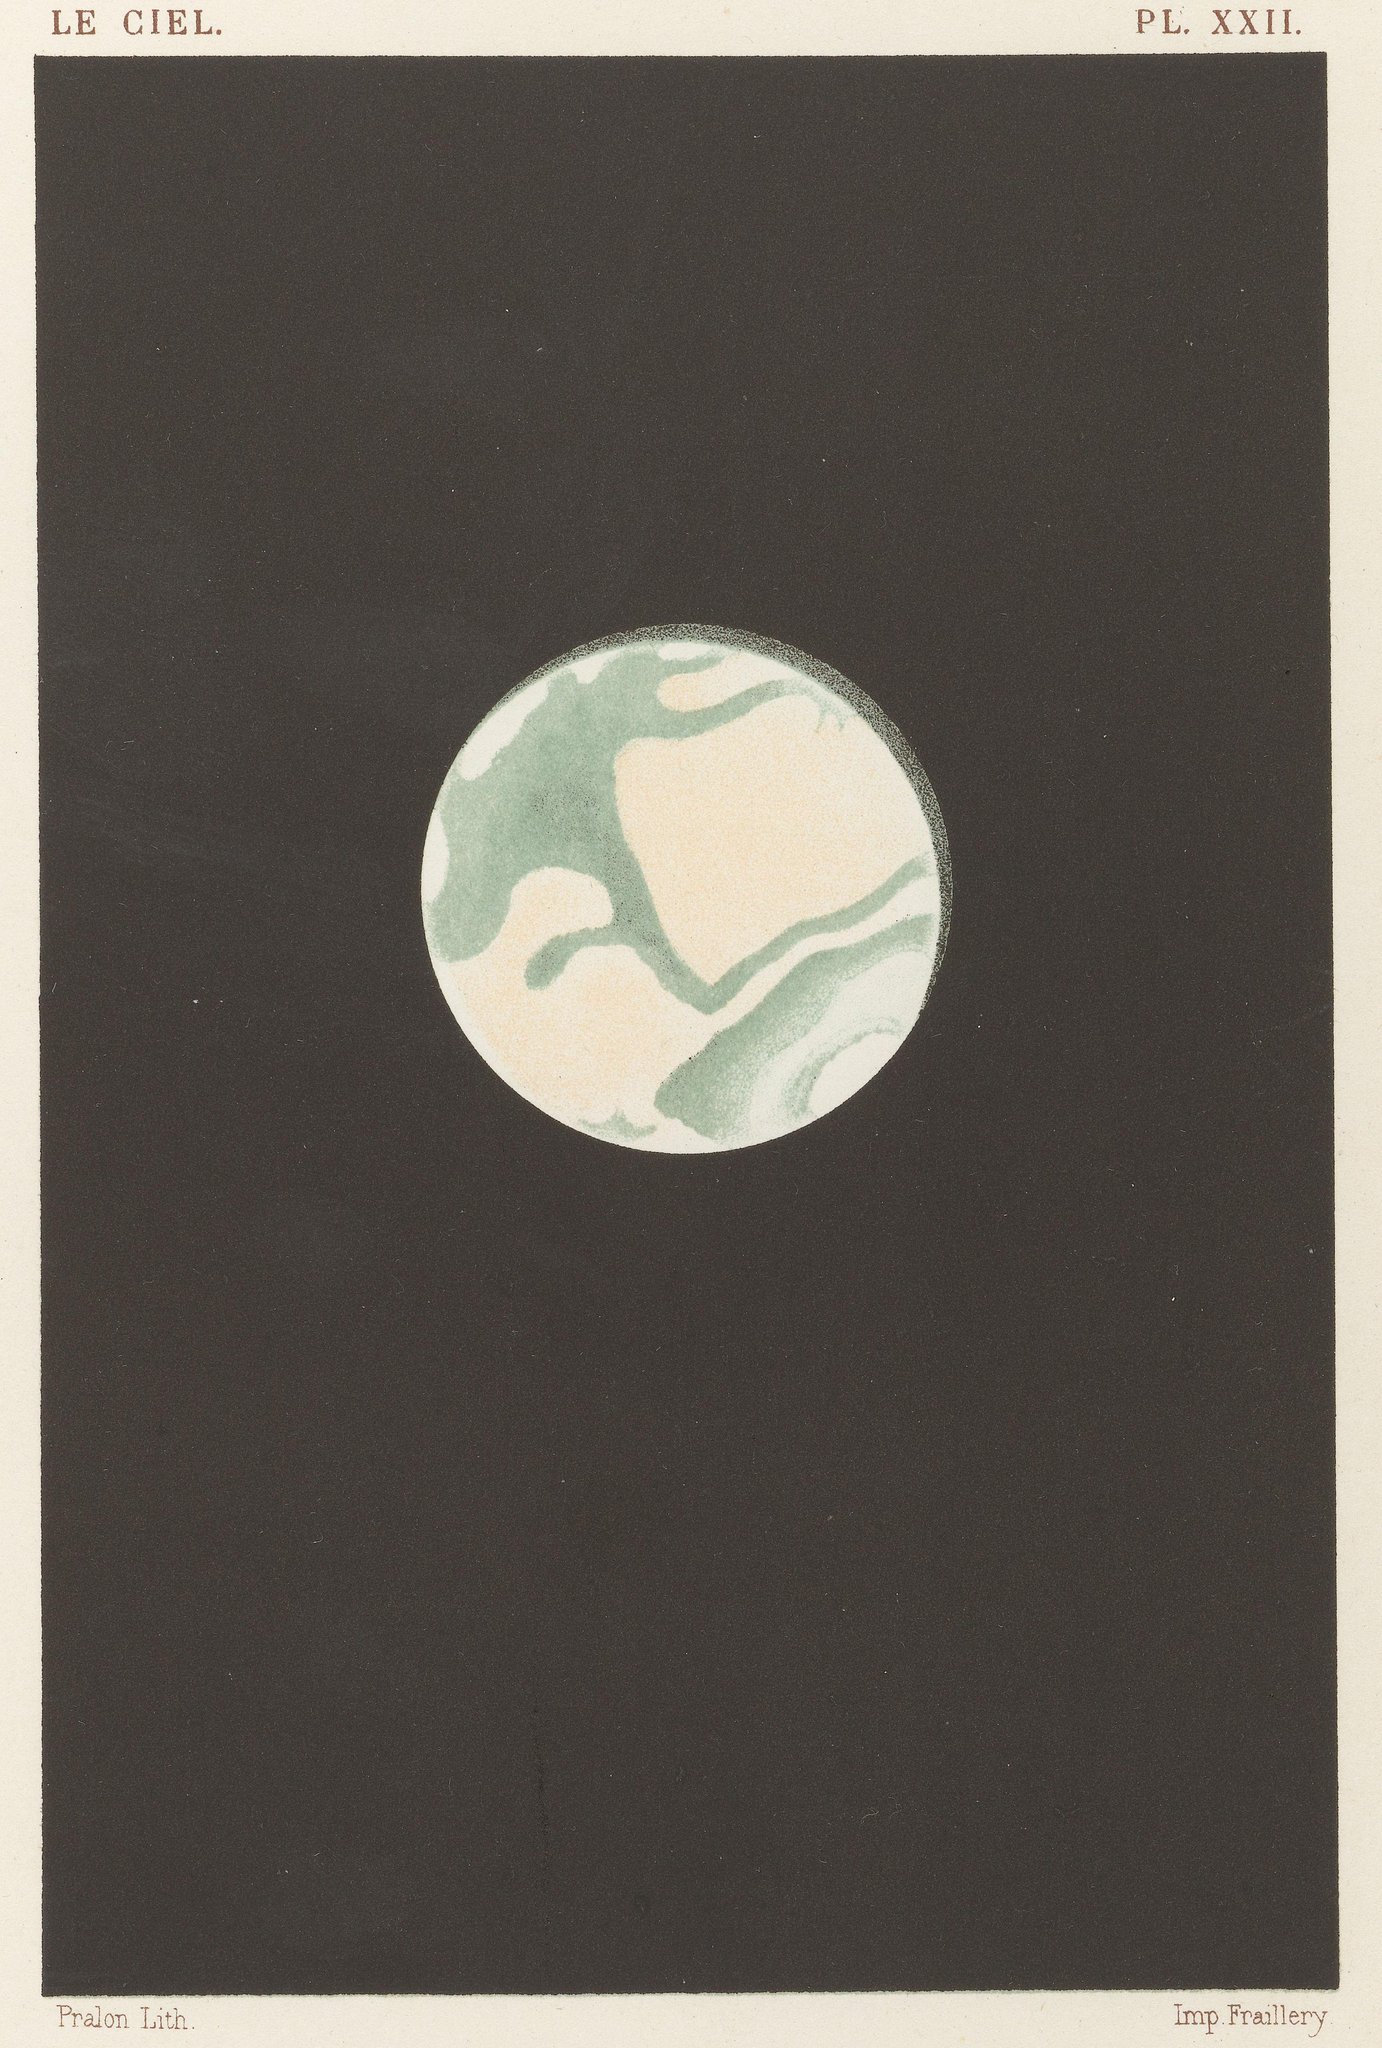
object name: print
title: Mars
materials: paper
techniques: lithograph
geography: paris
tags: mars (planet)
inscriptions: number: ‘Pl. XXII.’, inscription: ‘Le 27 mai 1873, d'après Proctor.’